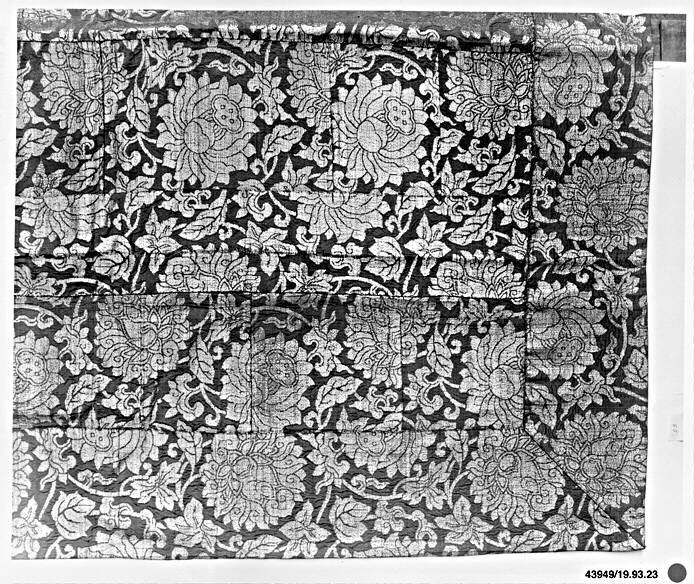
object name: robe, priest's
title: Seven-Panel Buddhist Monk’s Vestment (Shichijō kesa) with Peony Arabesque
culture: japanese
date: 1701-1800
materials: gold, silk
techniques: patterning, weave